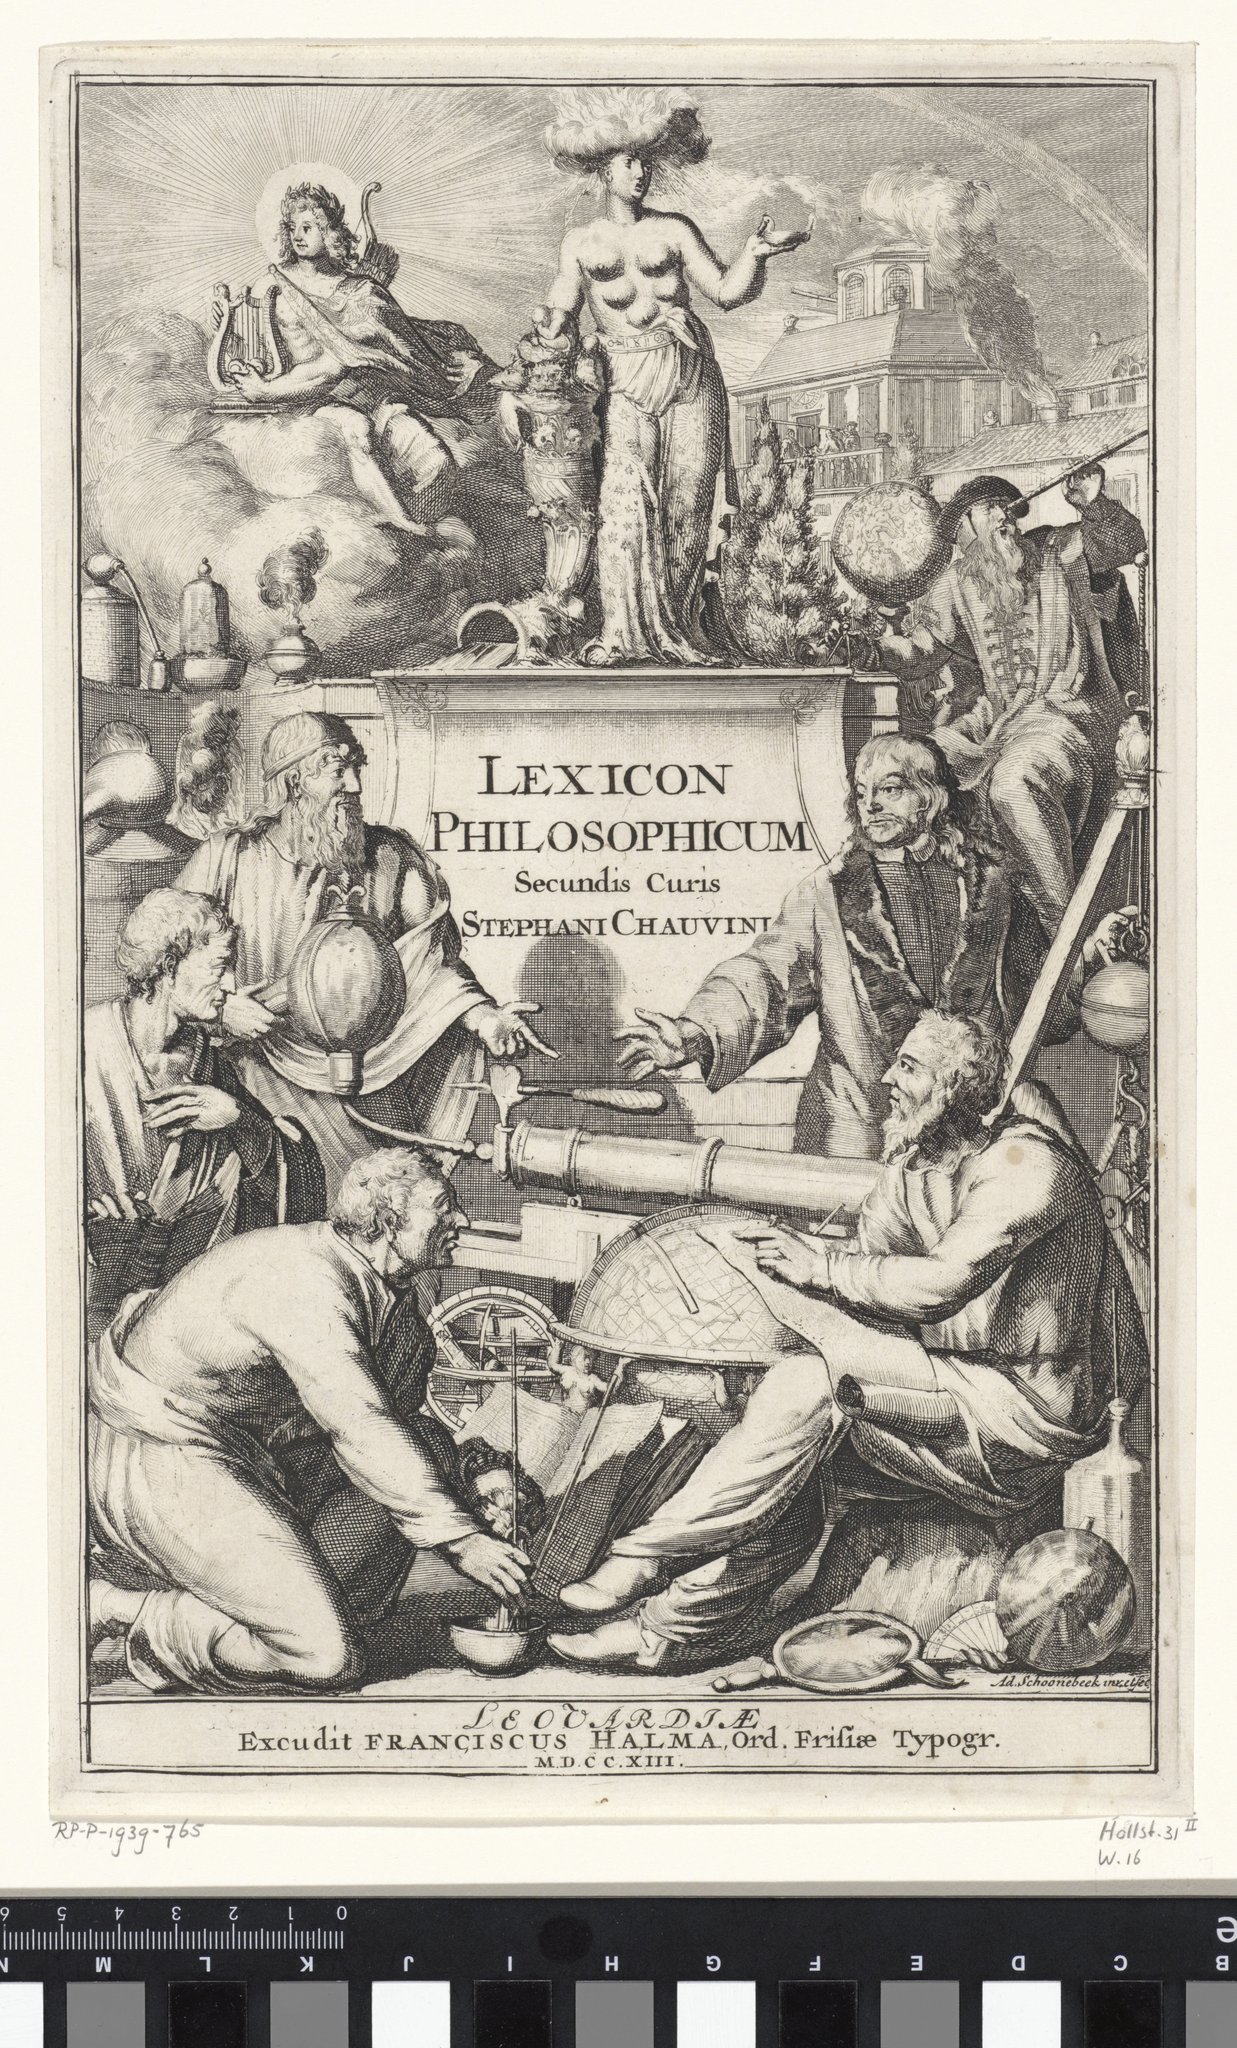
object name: print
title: Titelpagina voor S. Chauvin, Lexicon philosophicum, 1713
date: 1713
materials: paper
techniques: etching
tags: group of scholars or philosophers, measuring-instruments, telescope, specific aspects, allegorical aspects of apollo; apollo as patron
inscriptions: collector's mark: Lugt 2760, collector's mark: Lugt 2166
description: Rondom een standbeeld van Diana van Efeze, met op het voetstuk de titel van het boek en de naam van de auteur, bevindt zich een divers gezelschap van klassieke en moderne natuurwetenschappers. Zij hebben boeken en verschillende natuur-, schei- en sterrenkundige instrumenten bij zich. Onderaan het impressum.